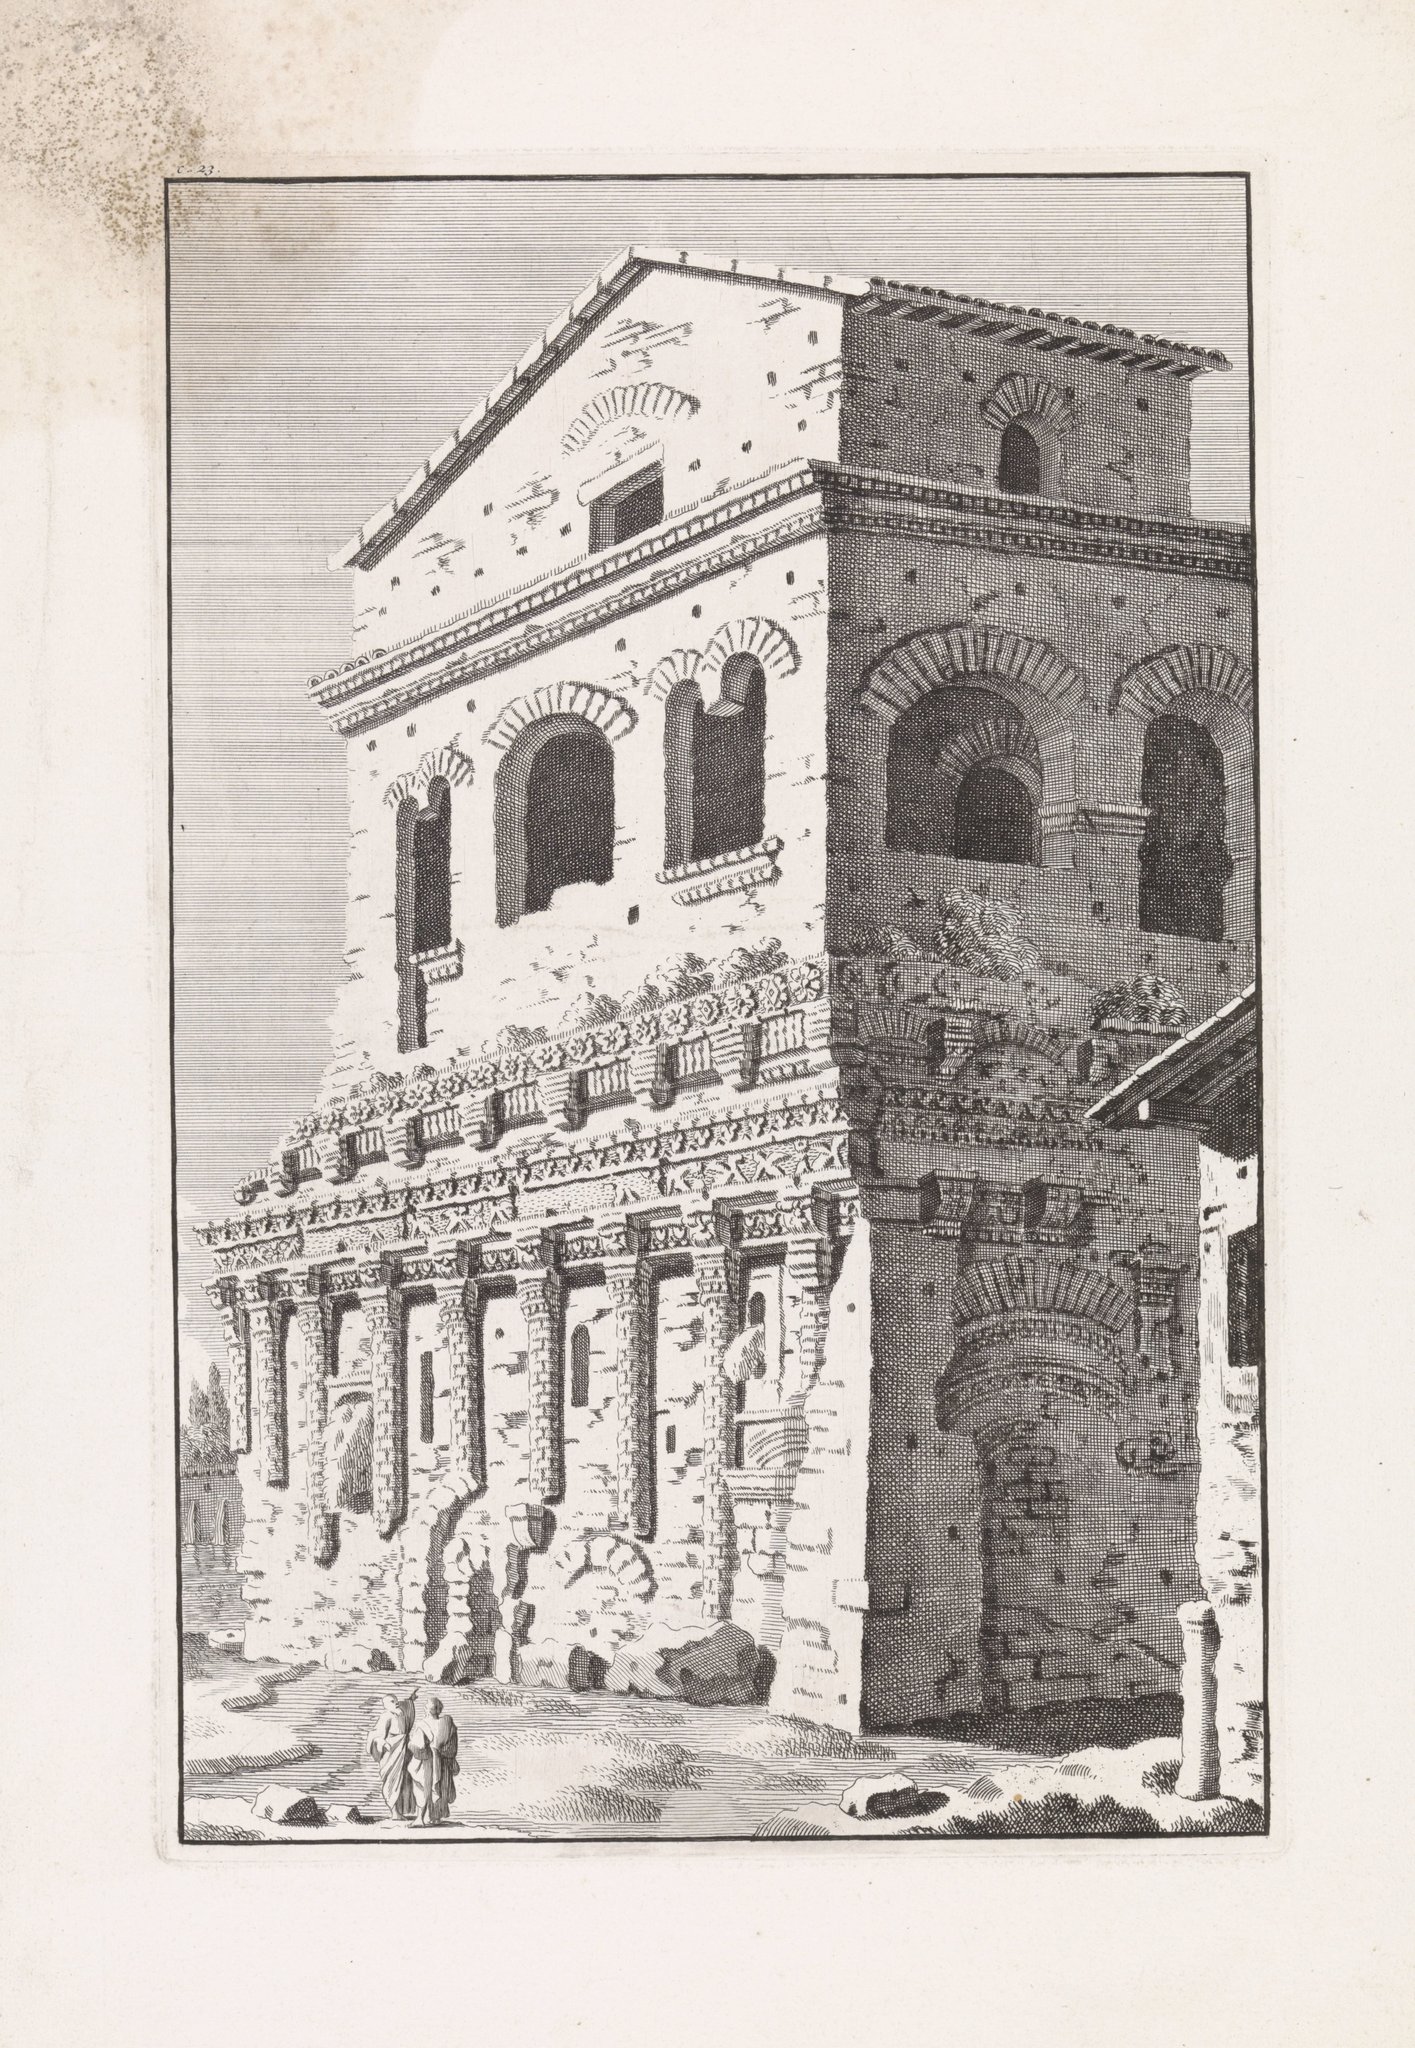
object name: print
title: Ruïne van een drie verdiepingen tellend gebouw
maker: bonaventura van overbeek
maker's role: draughtsman, print maker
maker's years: 1660-1706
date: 1708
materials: paper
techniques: etching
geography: amsterdam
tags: ruin of a building ~ architecture, rome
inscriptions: collector's mark: Lugt 2228